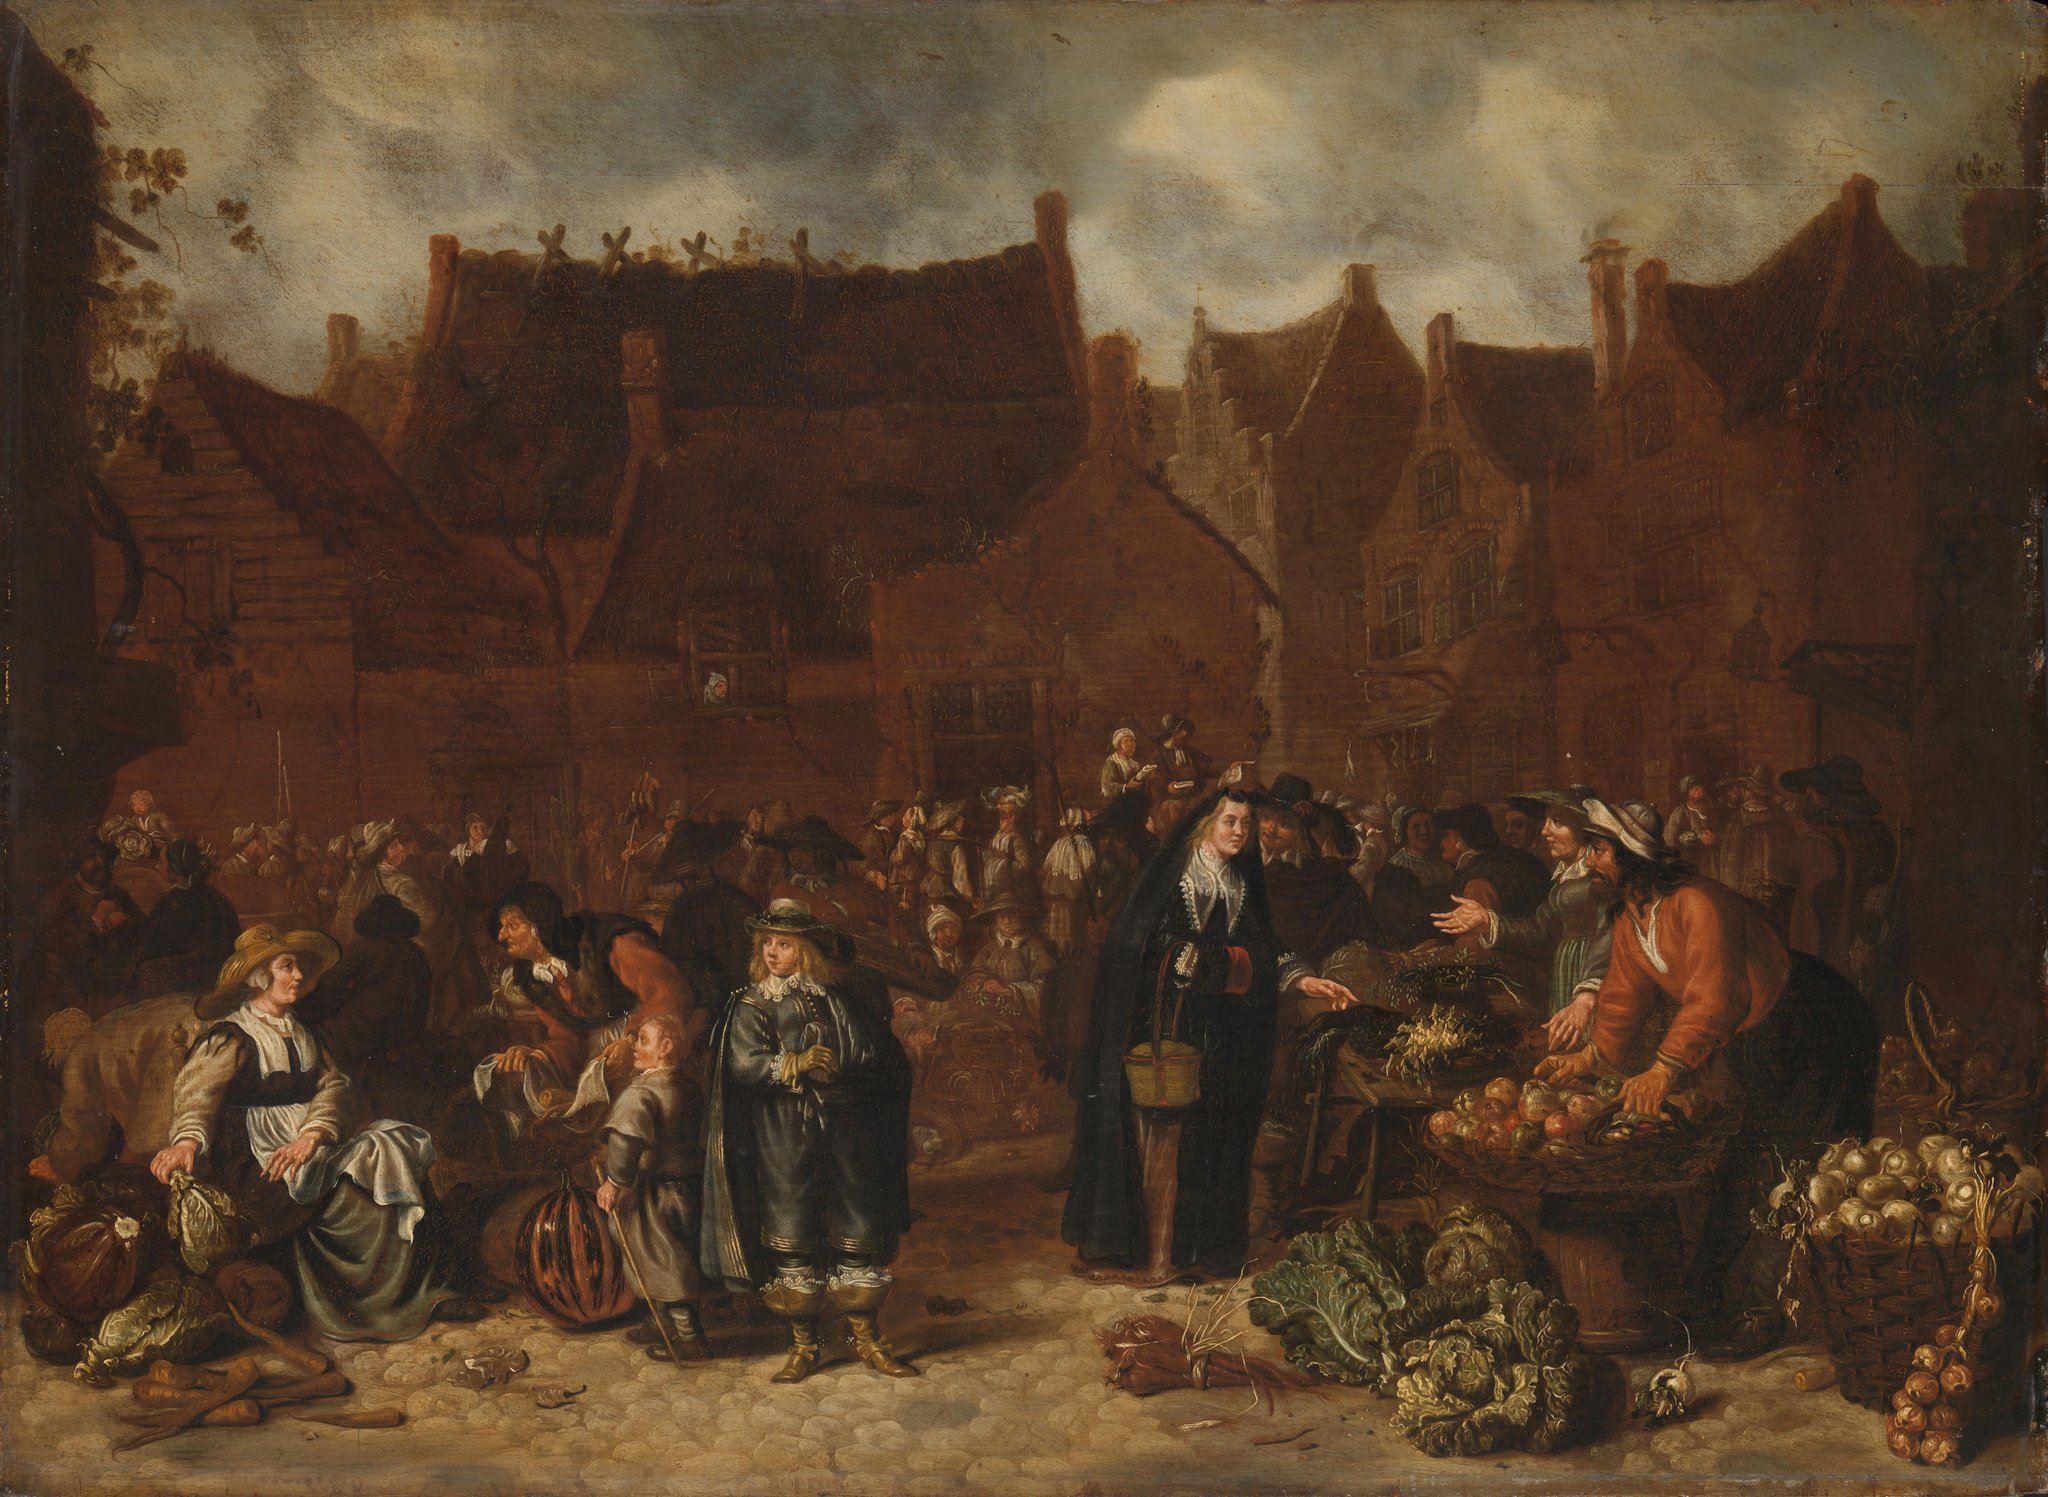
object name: painting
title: Vegetable Market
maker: sybrand van beest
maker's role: draughtsman, painter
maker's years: 1610-1674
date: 1646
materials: oil, panel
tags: vegetables, market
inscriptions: signature and date, bottom right on the barrel (v and B ligated): ‘S. vBeest / 1646’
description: Groentemarkt met winkelend publiek. Rechts een marktverkoper met kolen, uien en rapen, links een zittend vrouw met kolen, wortels en een kalebas.